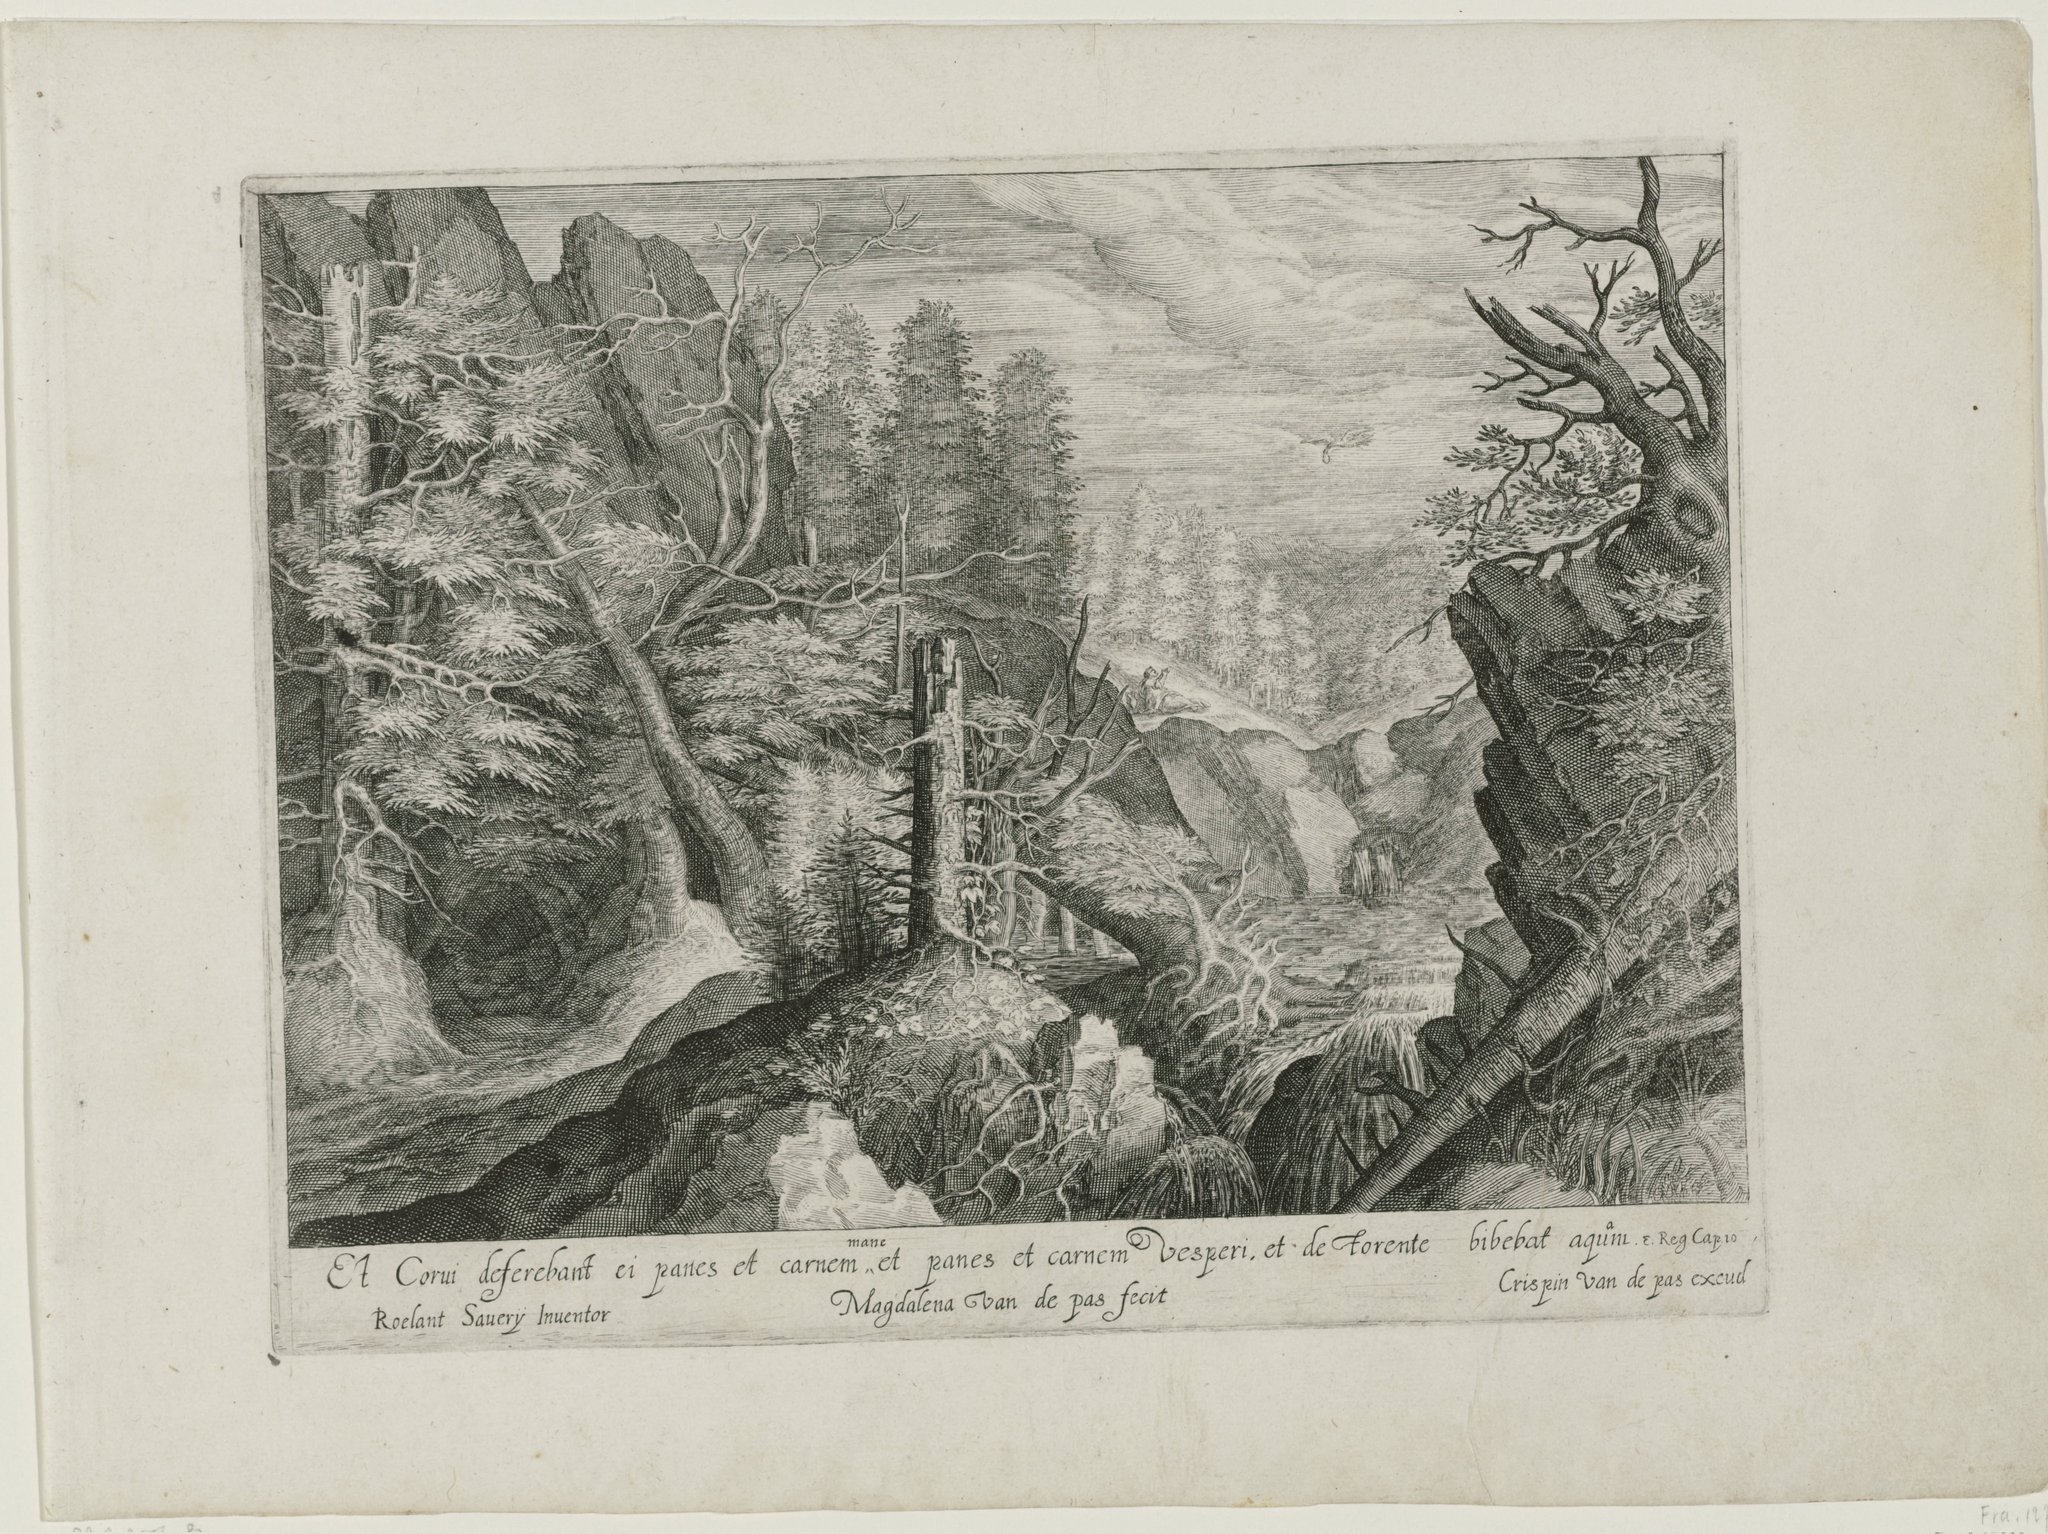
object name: print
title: Landscapes with the Story of Elijah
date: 1617-1634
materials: paper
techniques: engraving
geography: utrecht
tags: elijah fed by the raven(s): while the prophet is living by the brook, ravens bring him food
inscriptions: collector's mark: Lugt 2760, collector's mark: Lugt 2228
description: Magdalena de Passe based these impressive landscapes on paintings by the landscape painters Adam Willaerts and Roelant Savery. On her own initiative, the printmaker turned them into a narrative series by incorporating in them scenes from the life of the prophet Elijah. De Passe’s subtle engraving technique comes into its own in the rocky outcrops, waters and rolling hills. You can almost distinguish each leaf in the foliage of the trees.